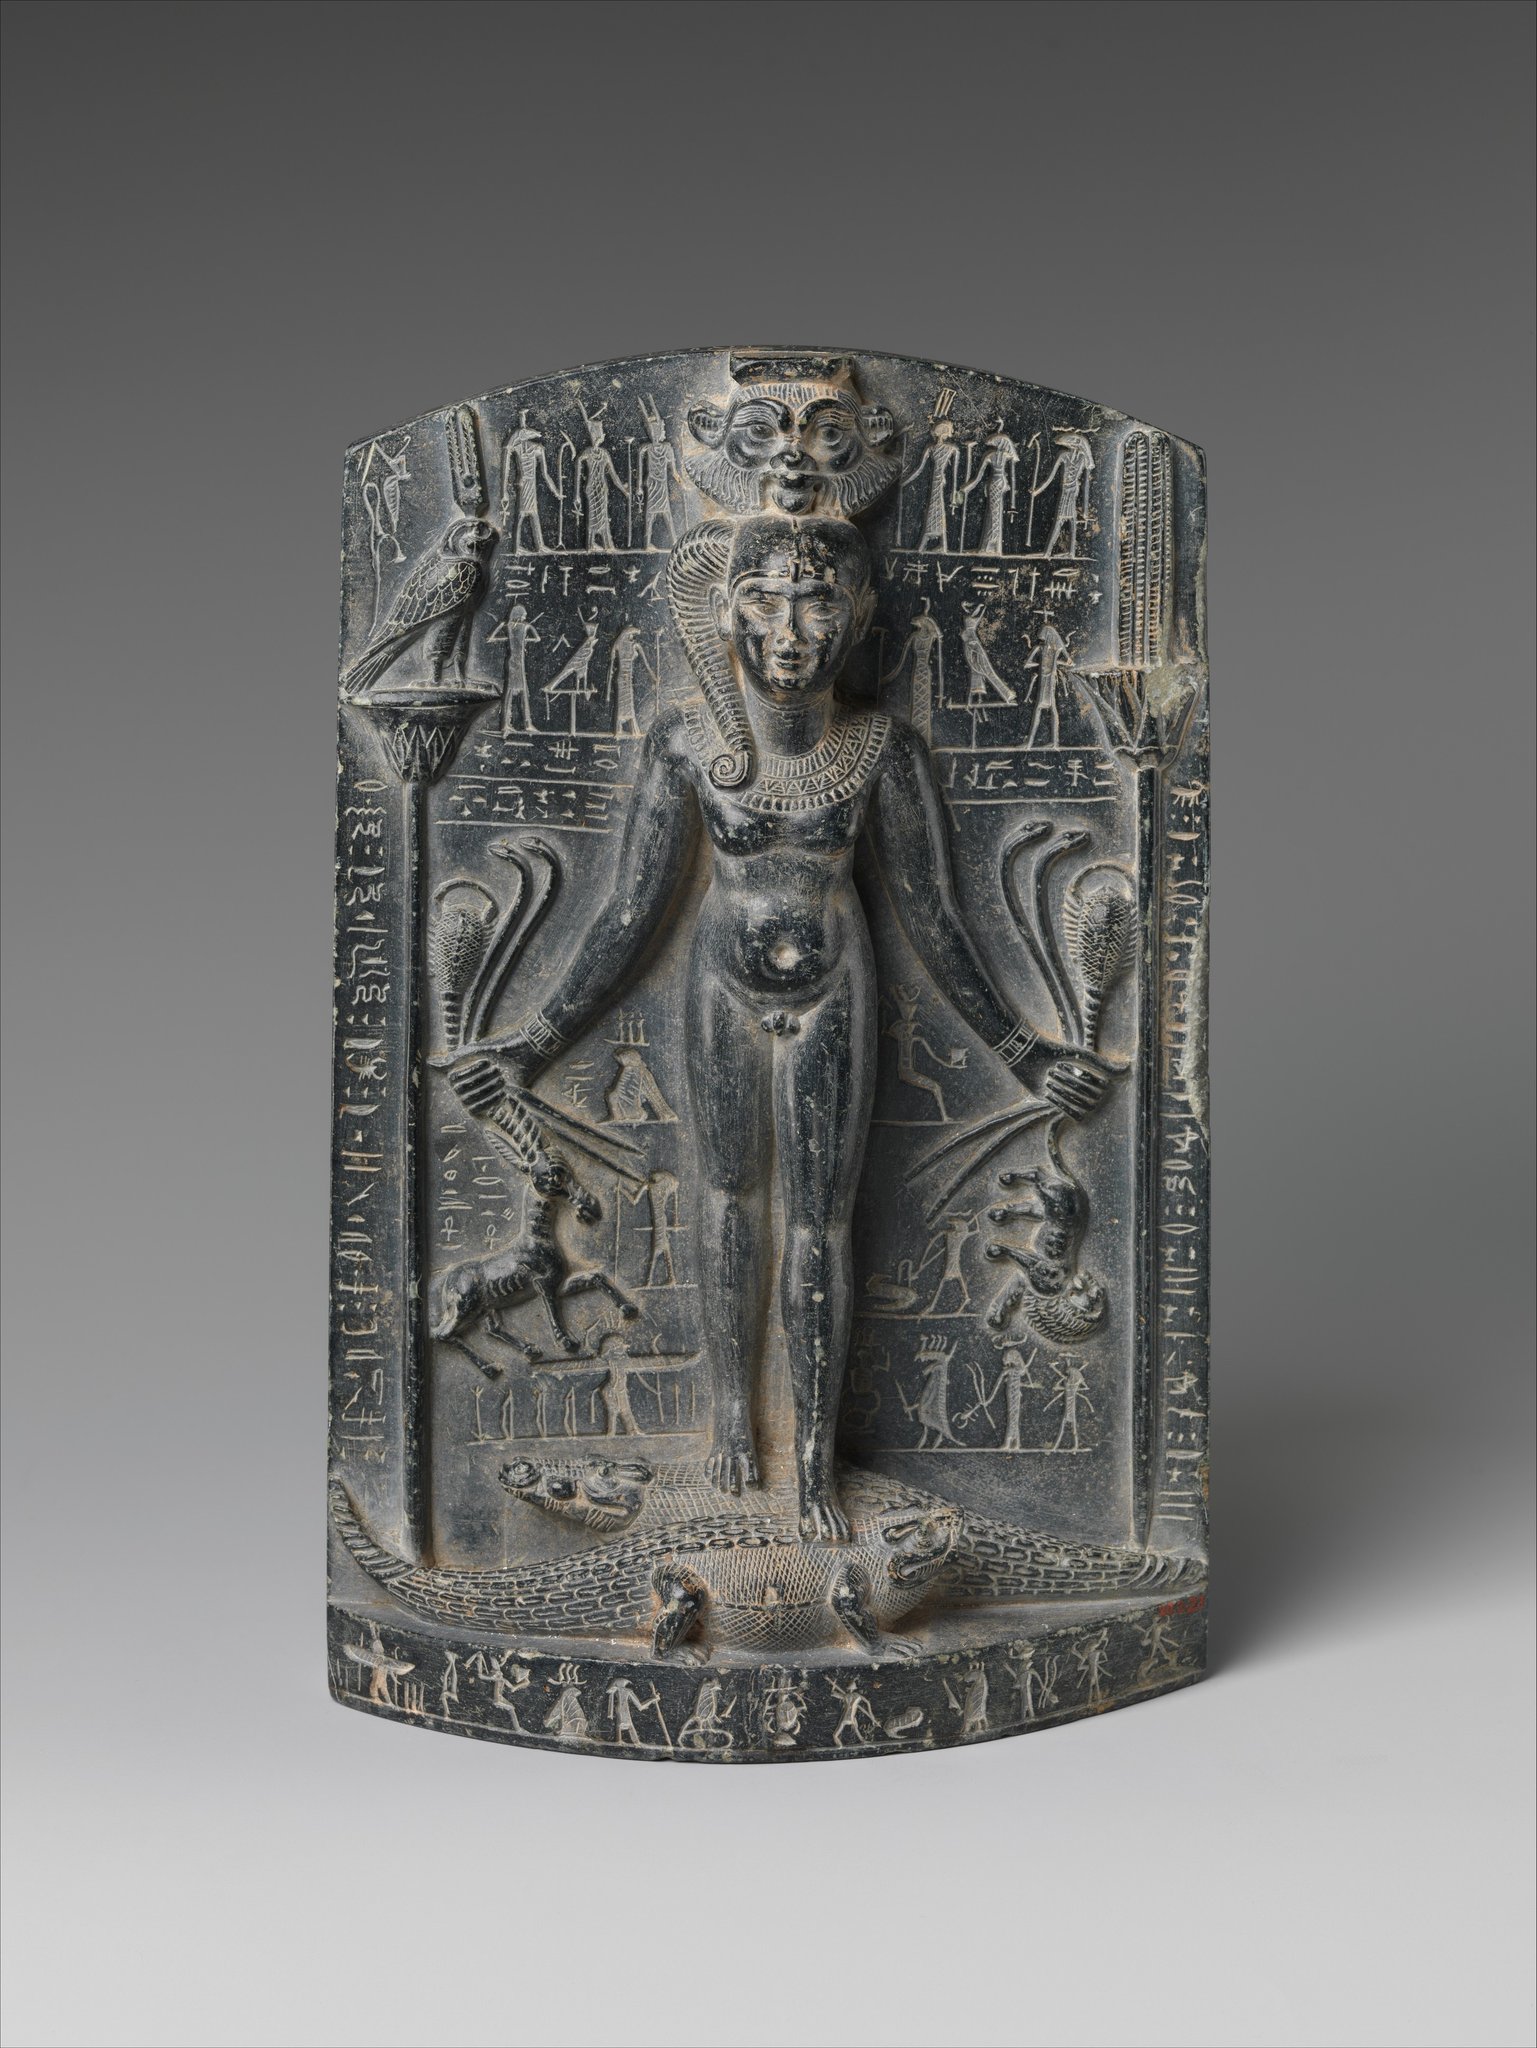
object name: cippus, horus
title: Magical stela or cippus of Horus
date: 332-280 BCE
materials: mineral, stone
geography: egypt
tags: animals,hieroglyphs,horus